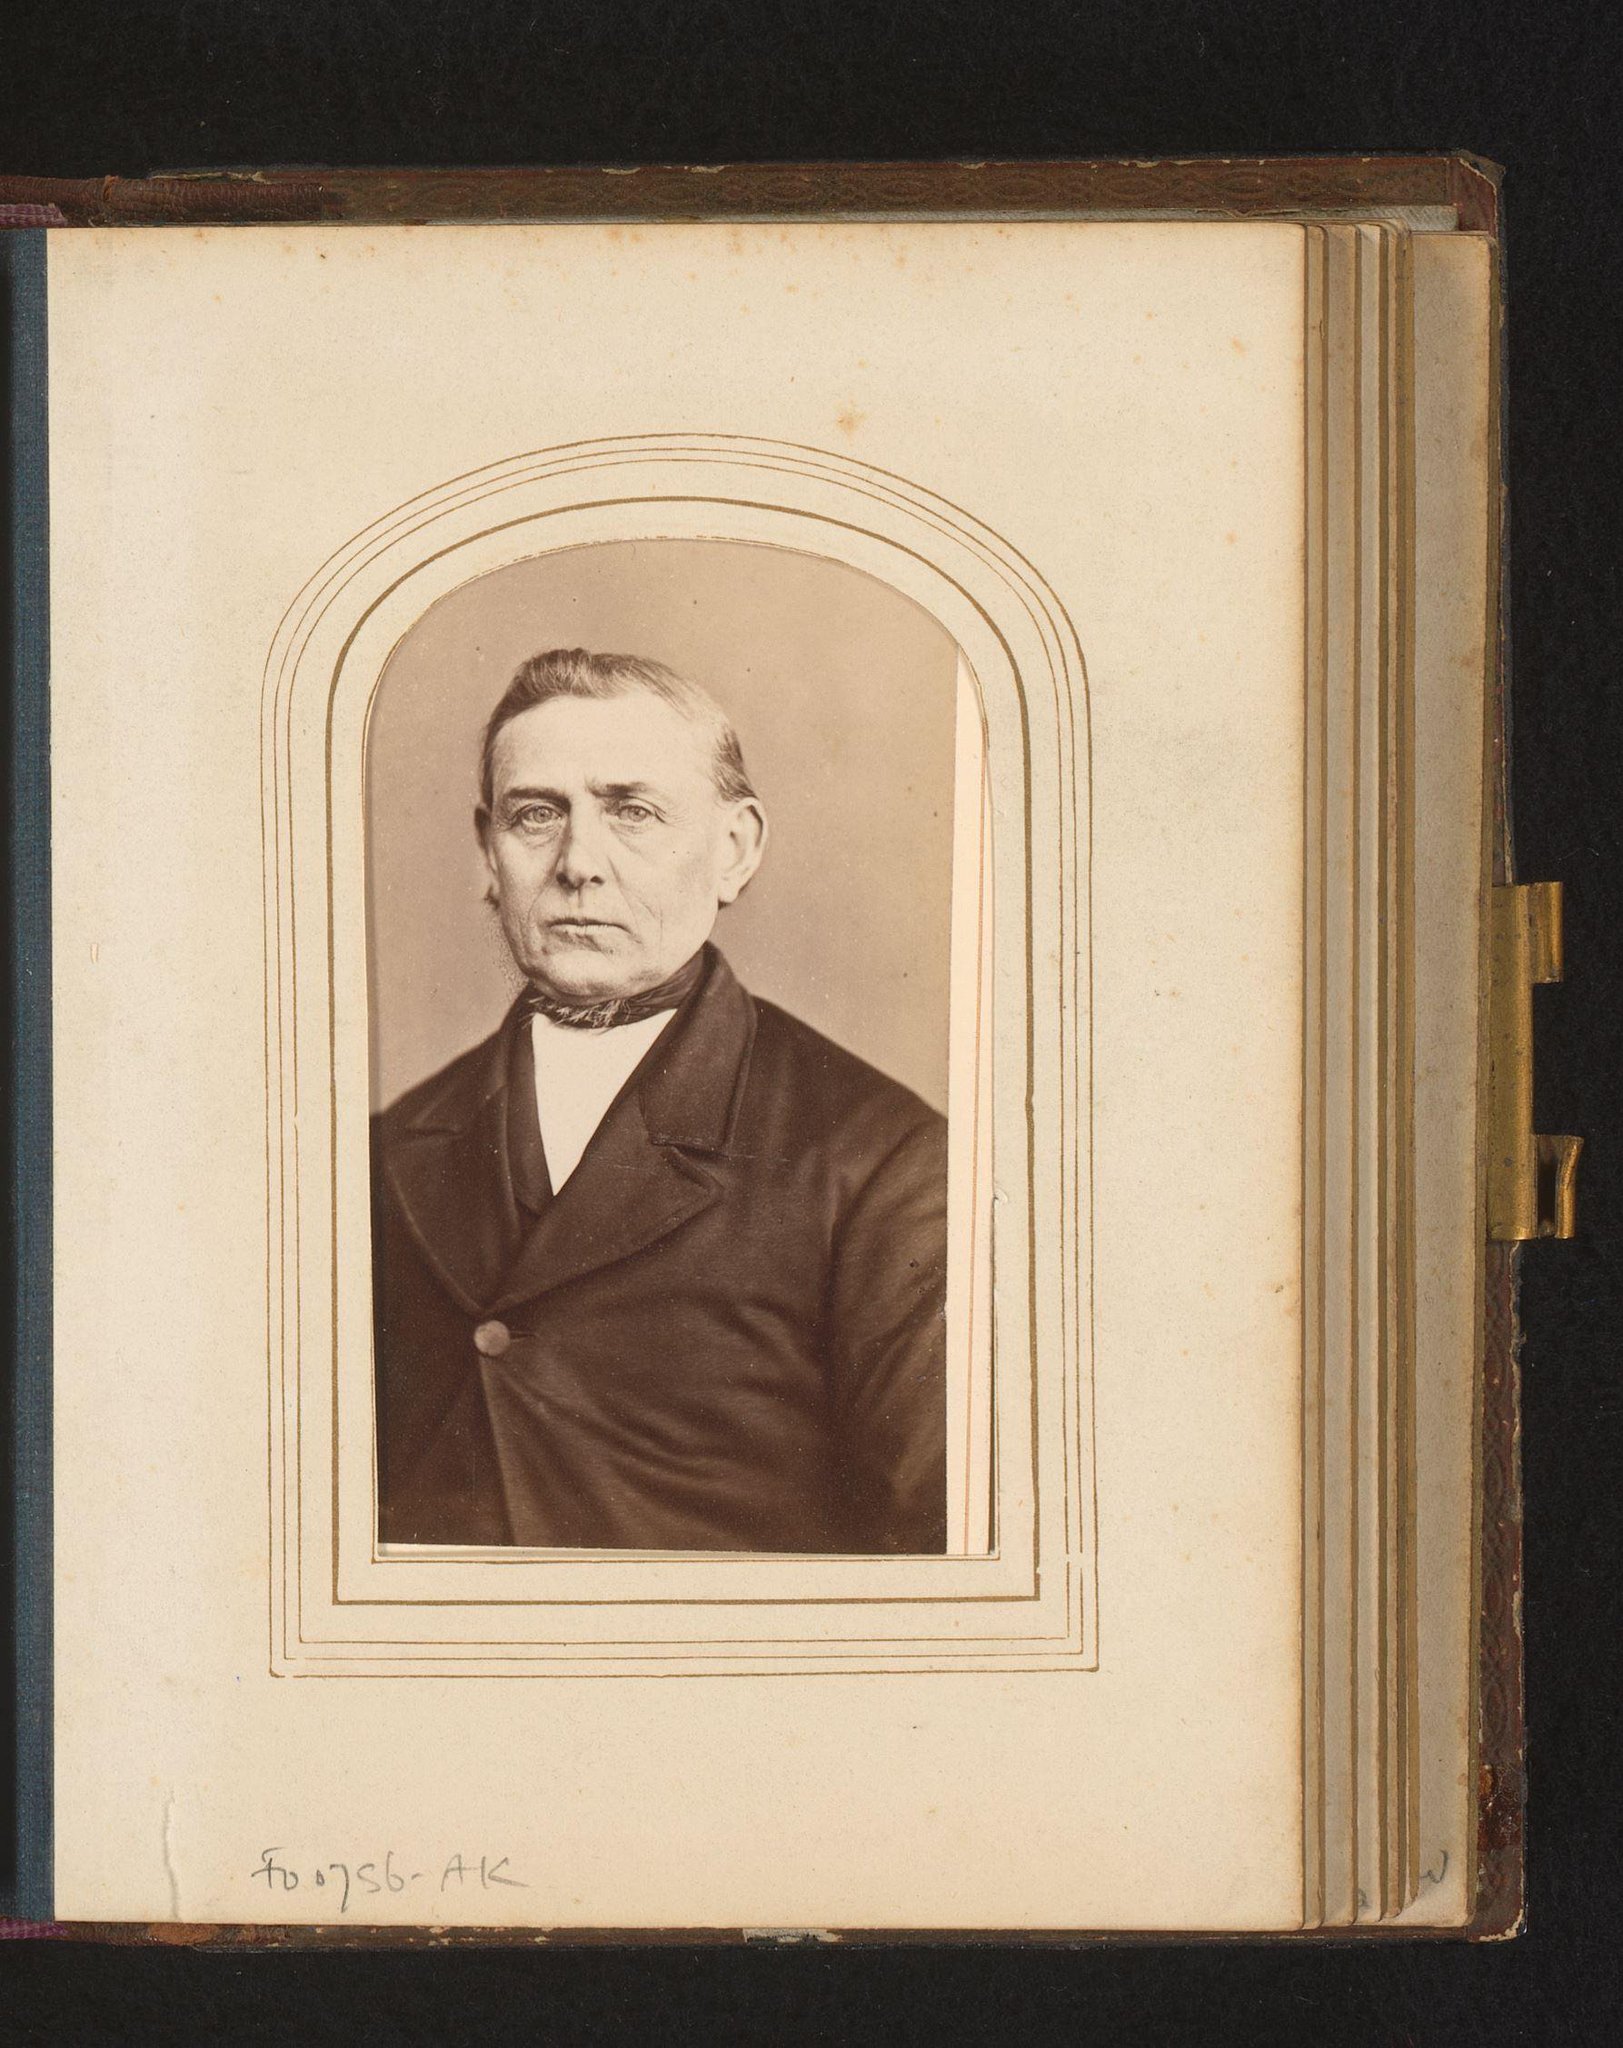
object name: album leaf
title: Portret van een man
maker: roelof hinderikus christiaan karsses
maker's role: fotograaf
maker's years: 1845-1941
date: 1860-1900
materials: cardboard, photographic support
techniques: albumen print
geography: groningen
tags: historical persons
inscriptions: inscription: ‘R.H.C. KARSSES/ Kunstschilder en Photograaf/ Heereweg/ over de Rabenhauptstraat Y.895./ Groningen./ Van deze Photographie kann nabesteld worden./ Onveranderlijke groote Photographiën, naar klein/ worden in alle afmetingen door mij vervaardigd.’